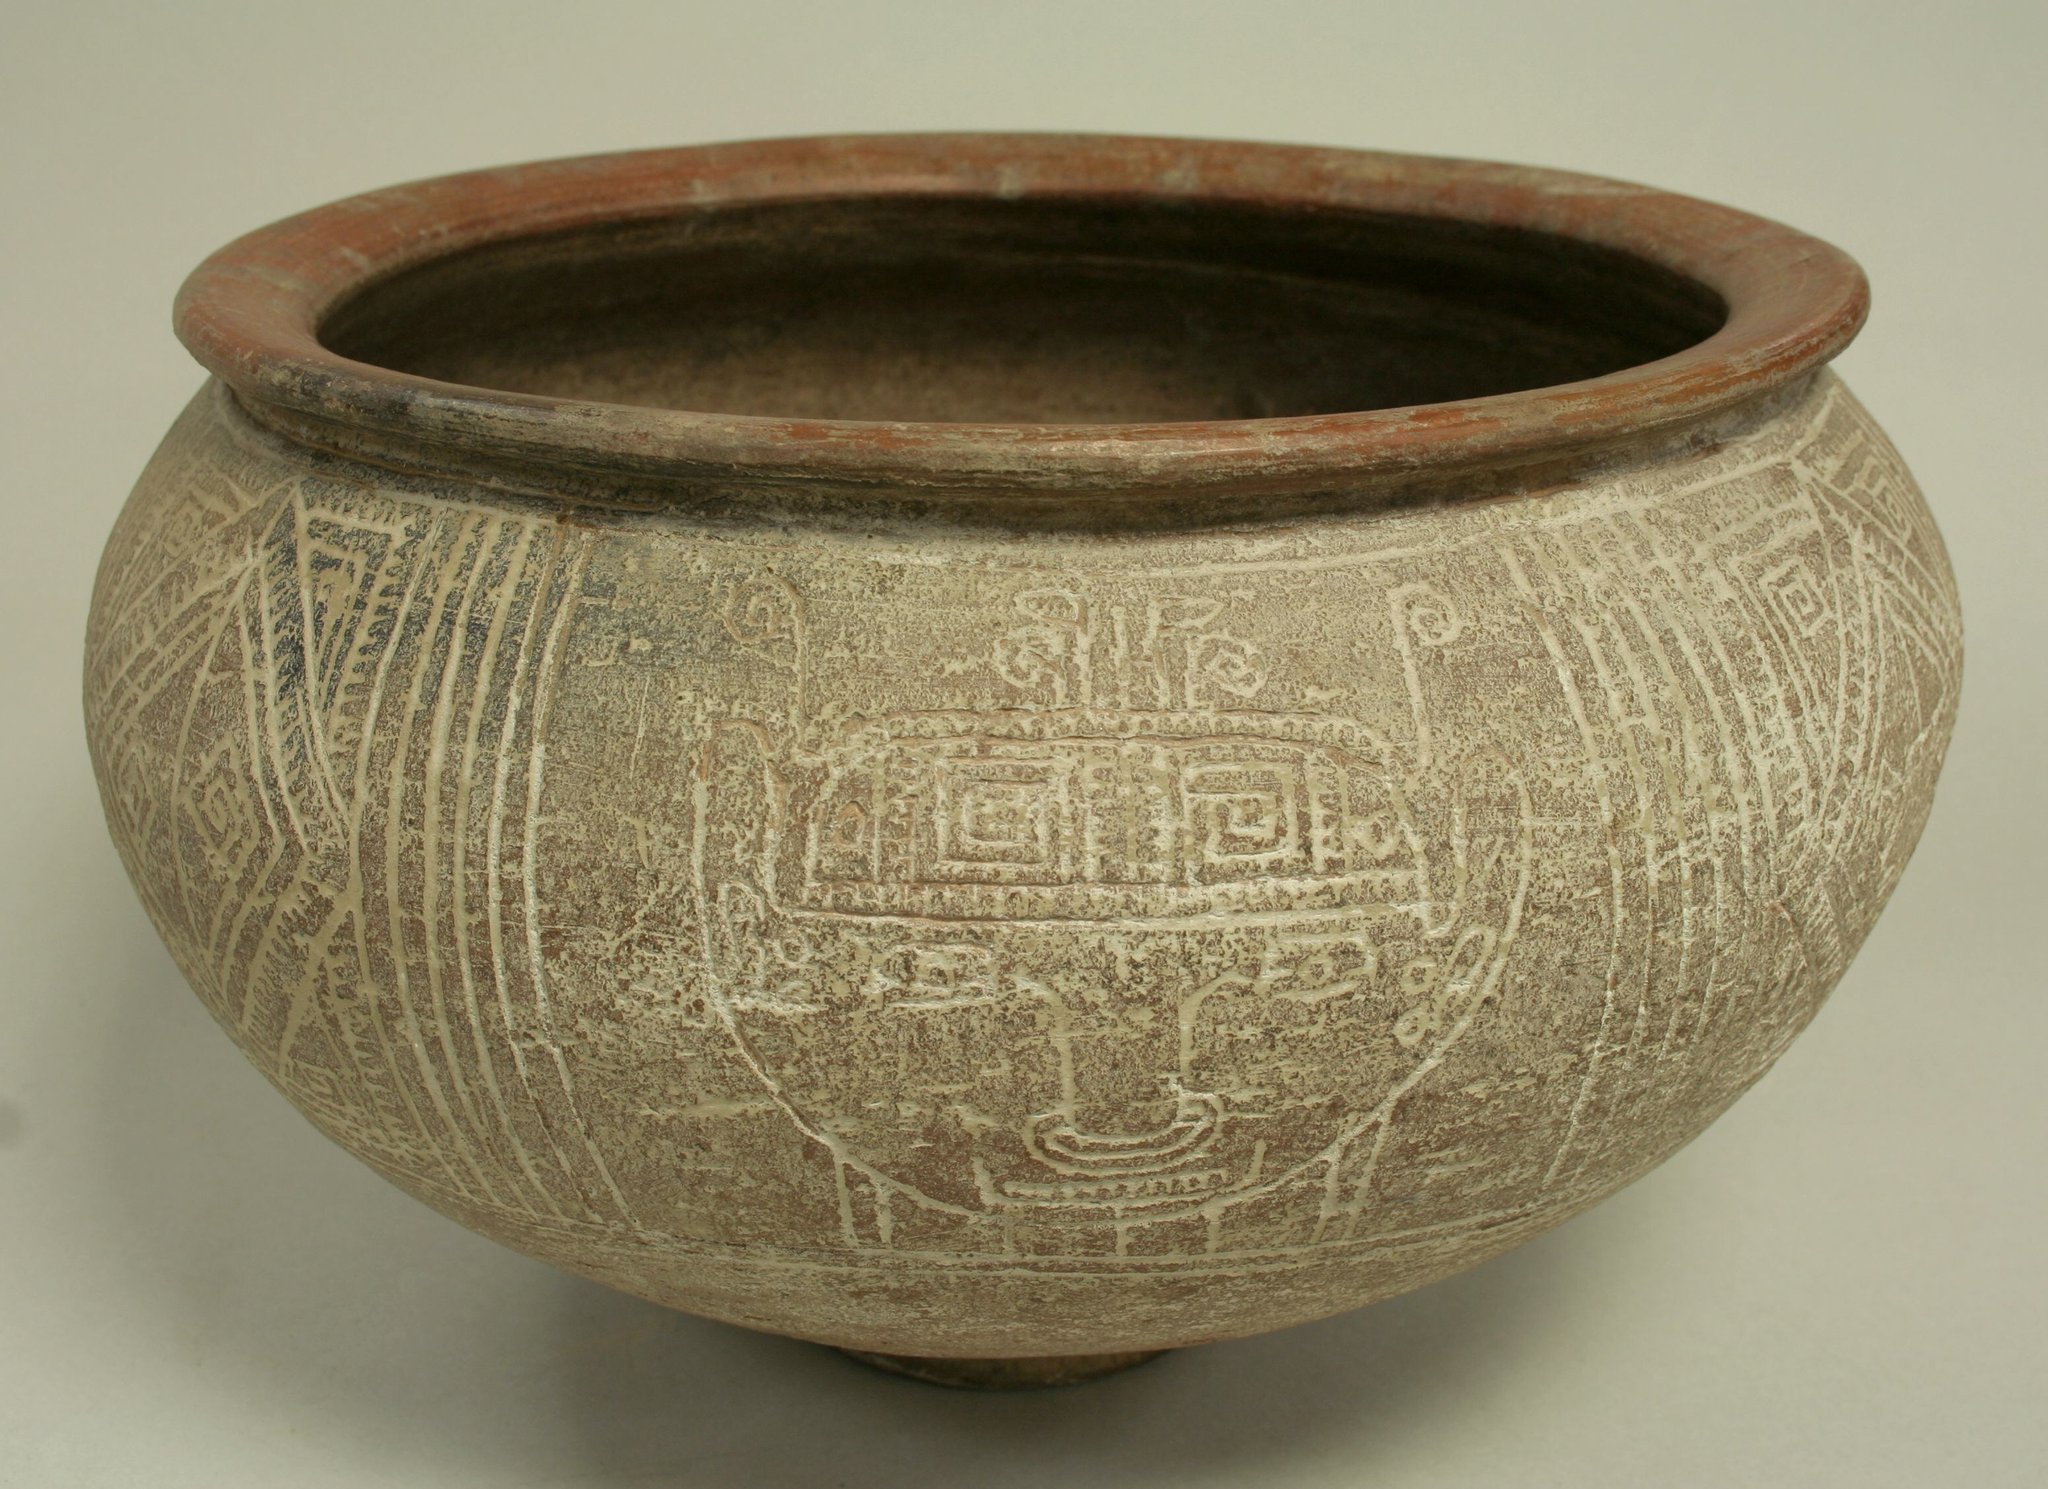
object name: bowl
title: Incised Bowl with Ring Base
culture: manteño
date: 501-1100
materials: ceramic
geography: ecuador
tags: faces